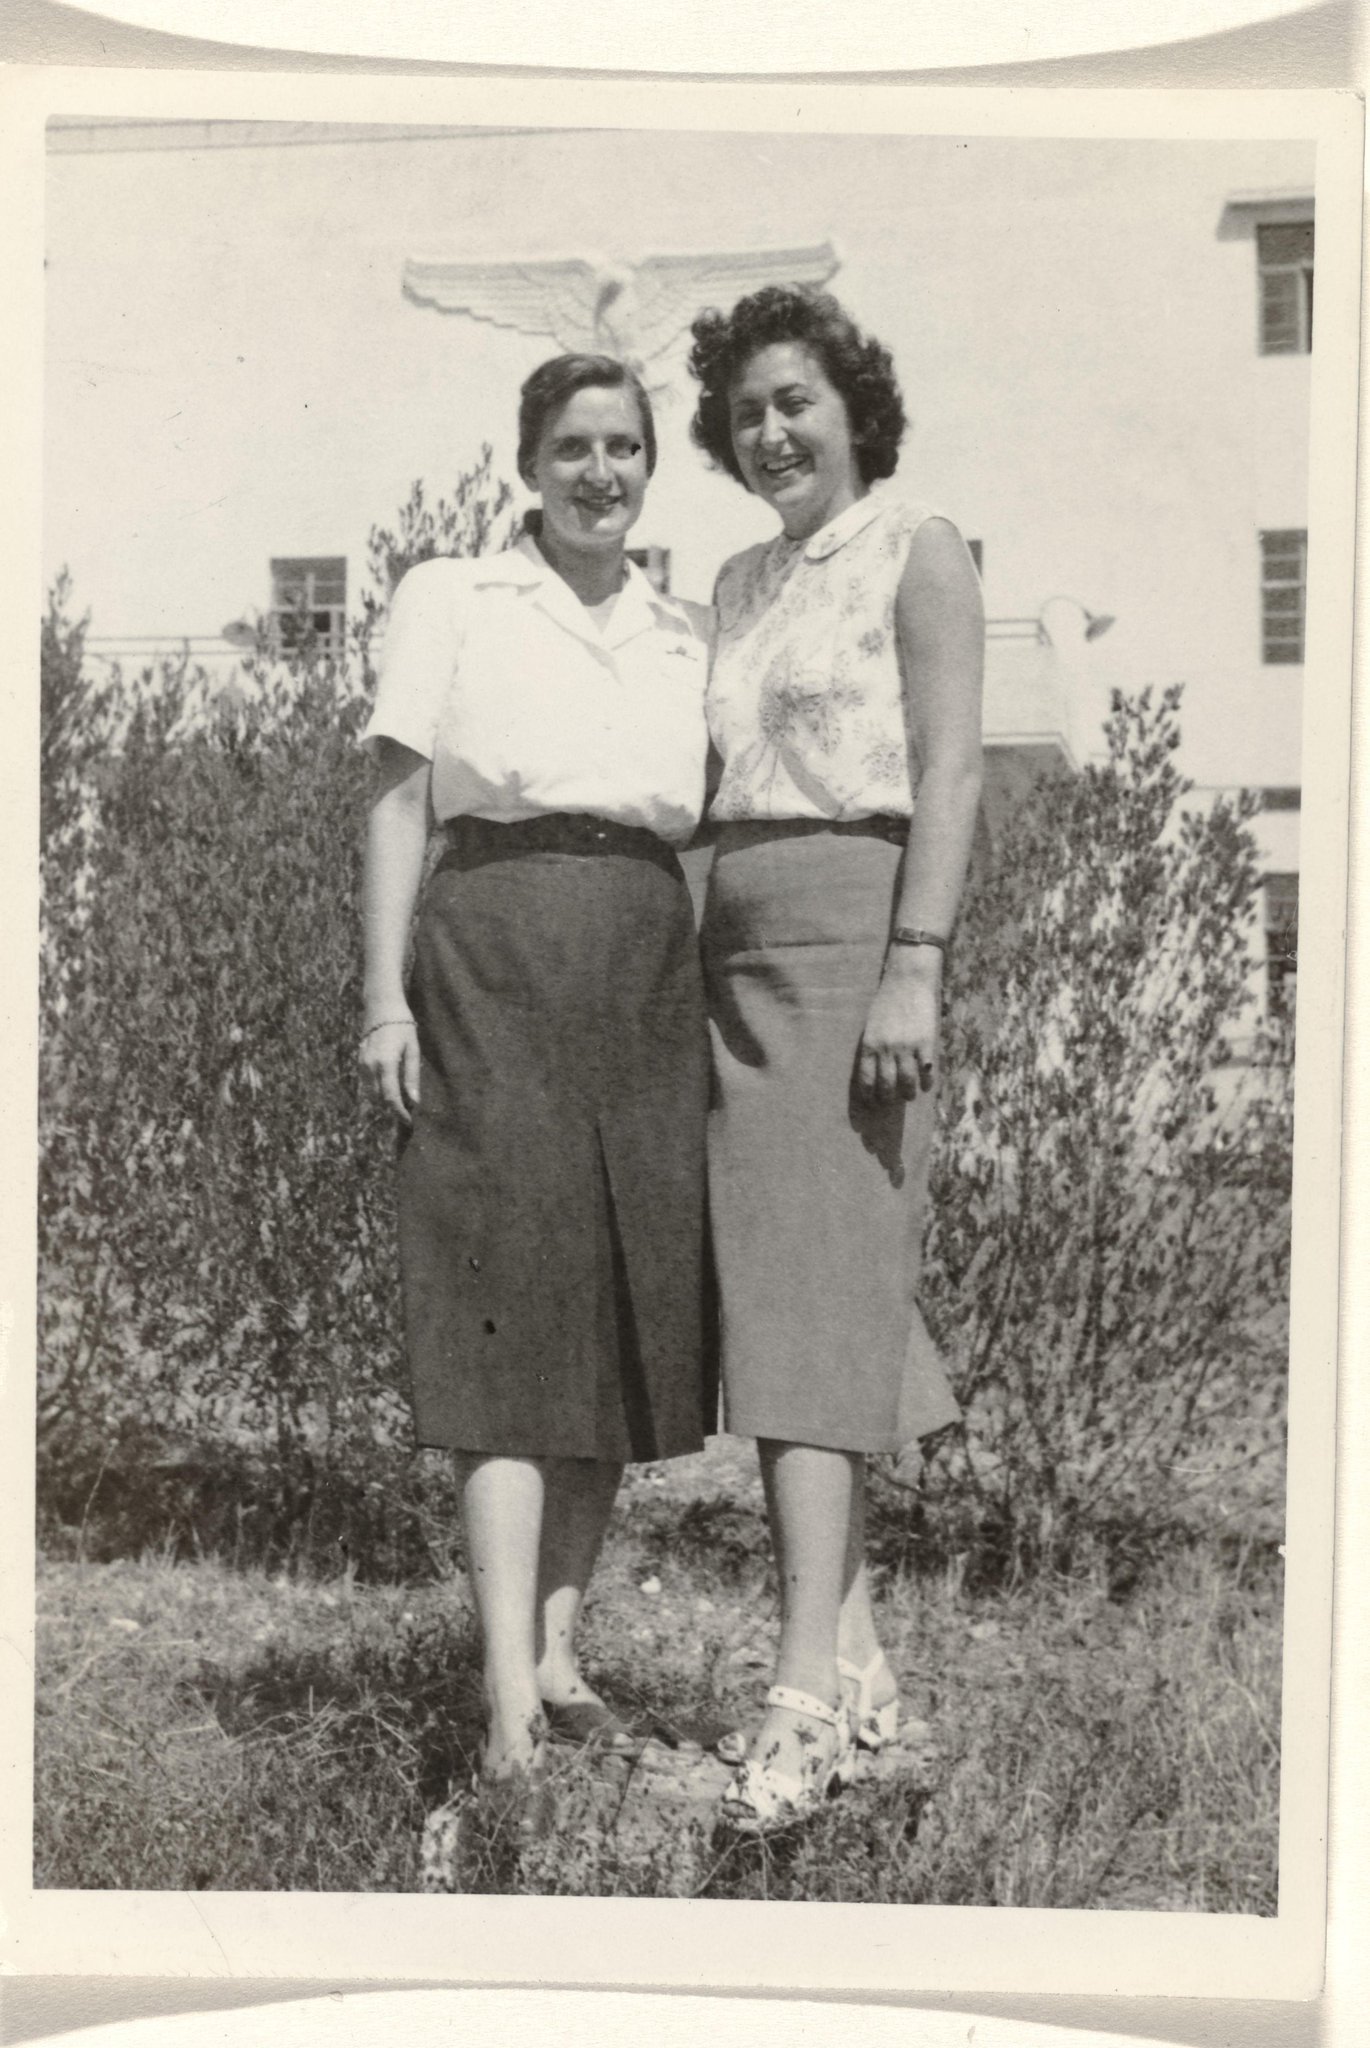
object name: photograph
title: Isabel Wachenheimer met onbekende vrouw, staand in een grasveld met een haag voor een gebouw met een gebeeldhouwde adelaar op de voorkant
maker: Anonymous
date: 1947-1955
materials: photographic support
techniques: gelatin silver print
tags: leiden, isabel wachenheimer-elon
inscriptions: inscription: ‘Phone 3823 Copyright by photo-attar (at the yard) 16, Mendele St. Tel-Aviv, Israël 8468’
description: Isabel Wachenheimer (links) met onbekende vrouw (rechts), staand in een grasveld met een haag voor een gebouw met een gebeeldhouwde adelaar op de voorkant.